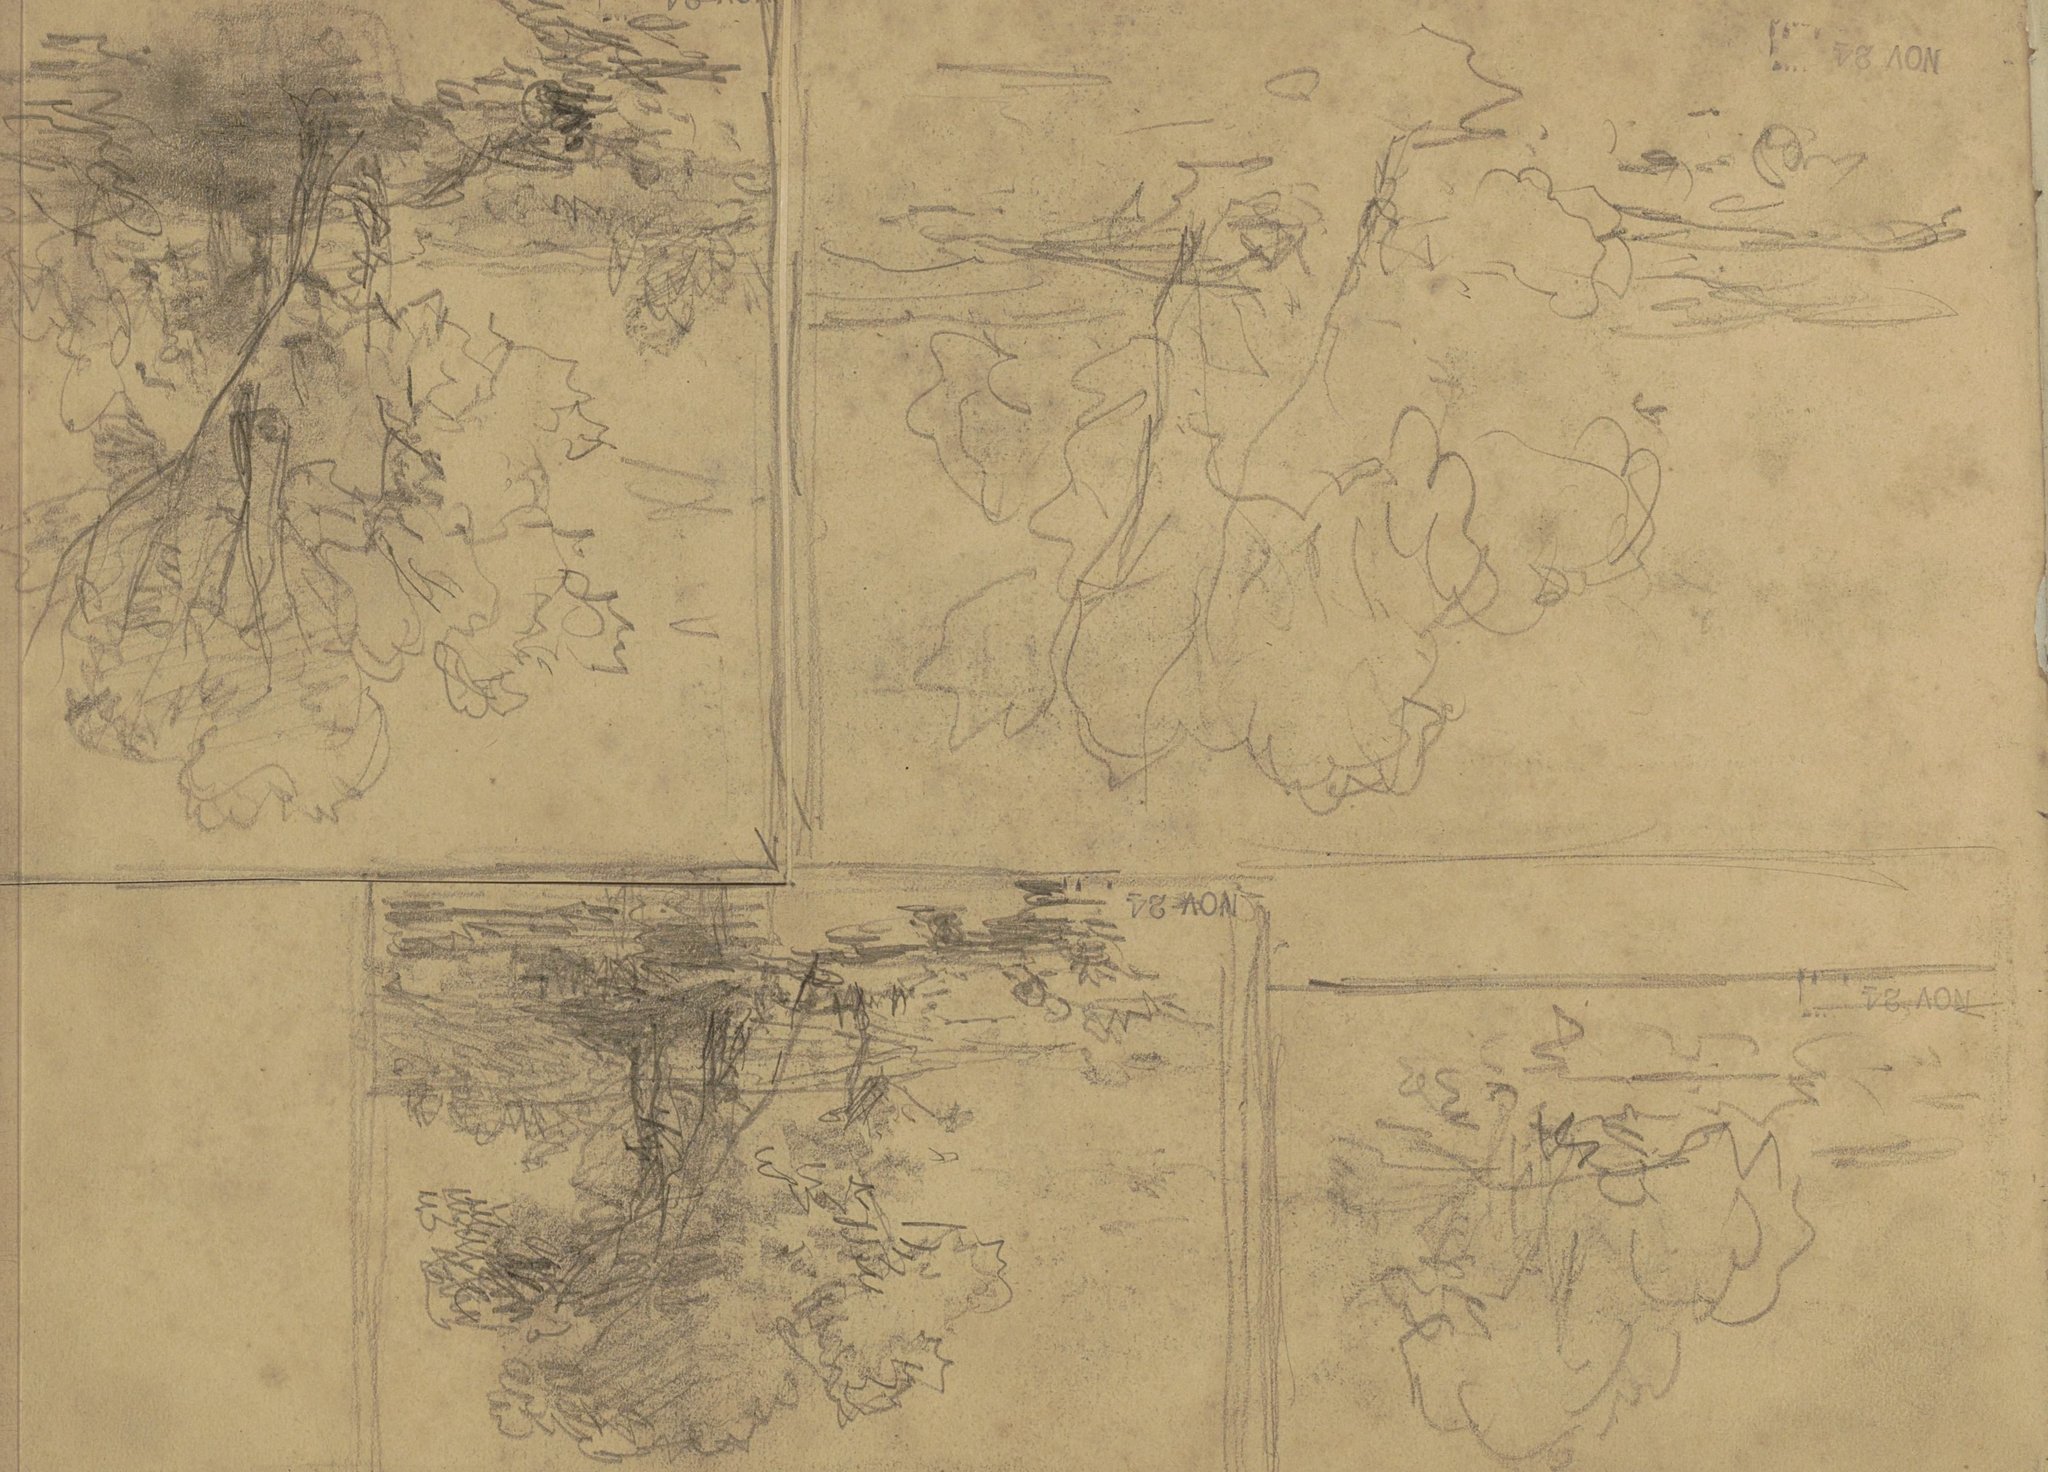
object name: sketchbook leaf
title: Landschappen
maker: willem roelofs (i)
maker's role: draughtsman, painter, print maker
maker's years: 1822-1897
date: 1846-1851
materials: paper, pencil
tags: landscapes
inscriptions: date: ‘NOV 24 , ,,/ NOV 24 , ,,/ NOV 24 , ,,/ NOV 24 , ,,’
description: Vier landschappen met bomen en water. Tekeningen in kaders. Blad 18 verso uit een schetsboek met 25 bladen.